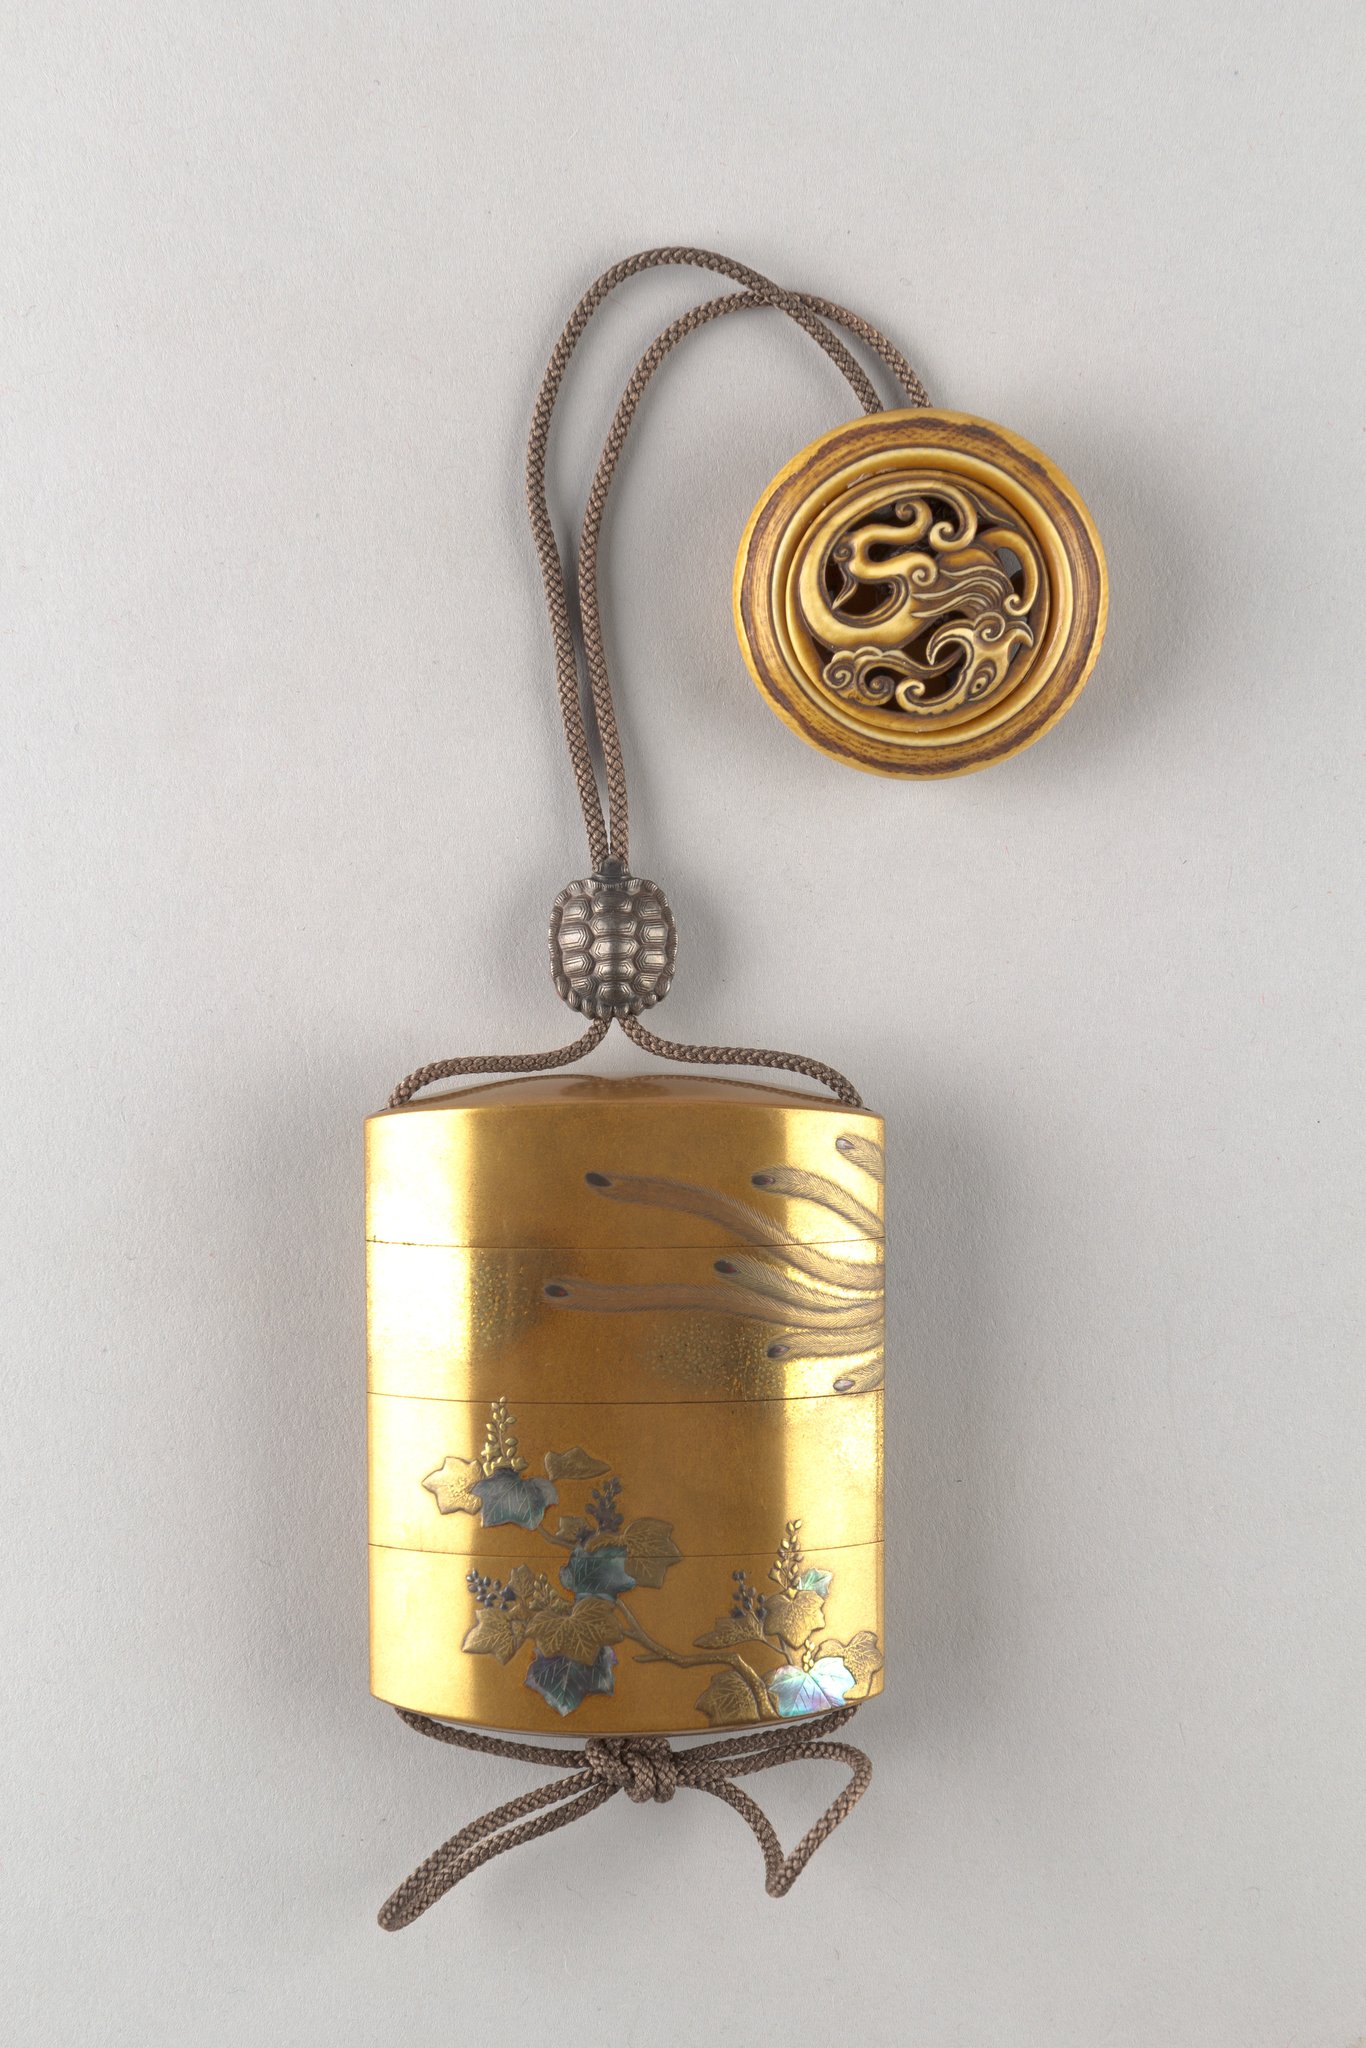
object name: inrō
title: Case (Inrō) with Pheonix and Paulownia Tree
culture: japanese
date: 1801-1900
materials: gold, lacquer, mother of pearl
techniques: maki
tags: birds,trees